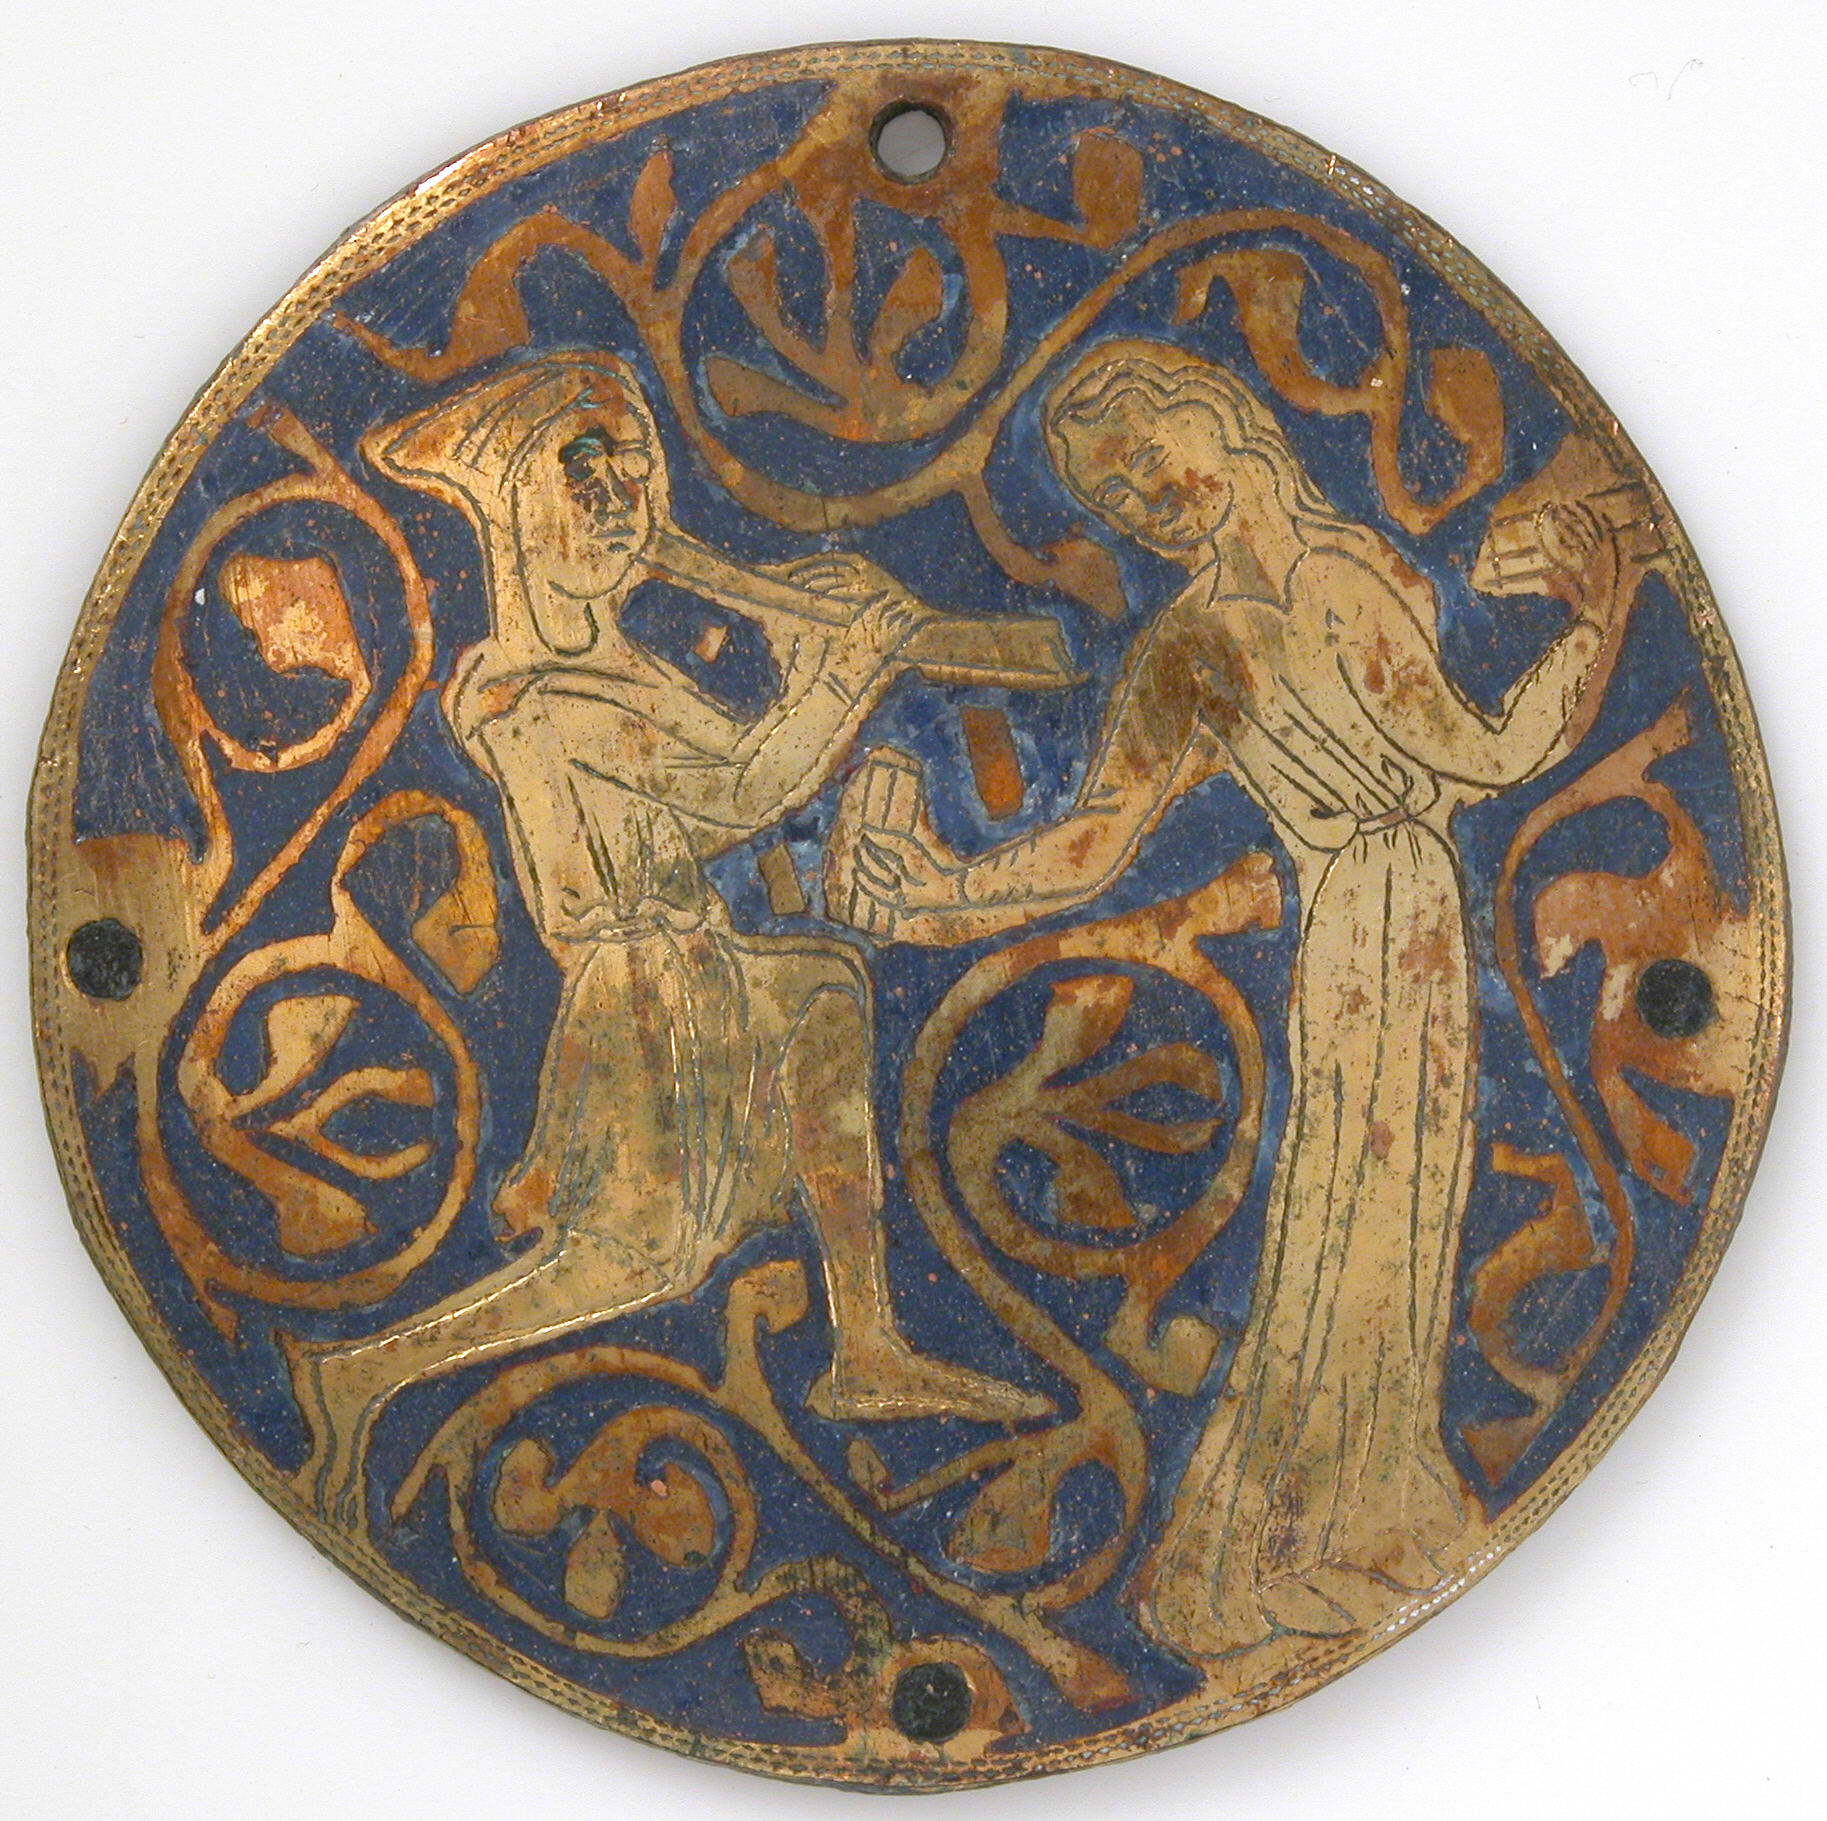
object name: medallion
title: Medallion with Youth Playing Pipe for Dancing Woman with Castanets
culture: french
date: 1240-1260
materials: copper, enamel, gilt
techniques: enamel, engraving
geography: france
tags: men,women,dancing,musicians